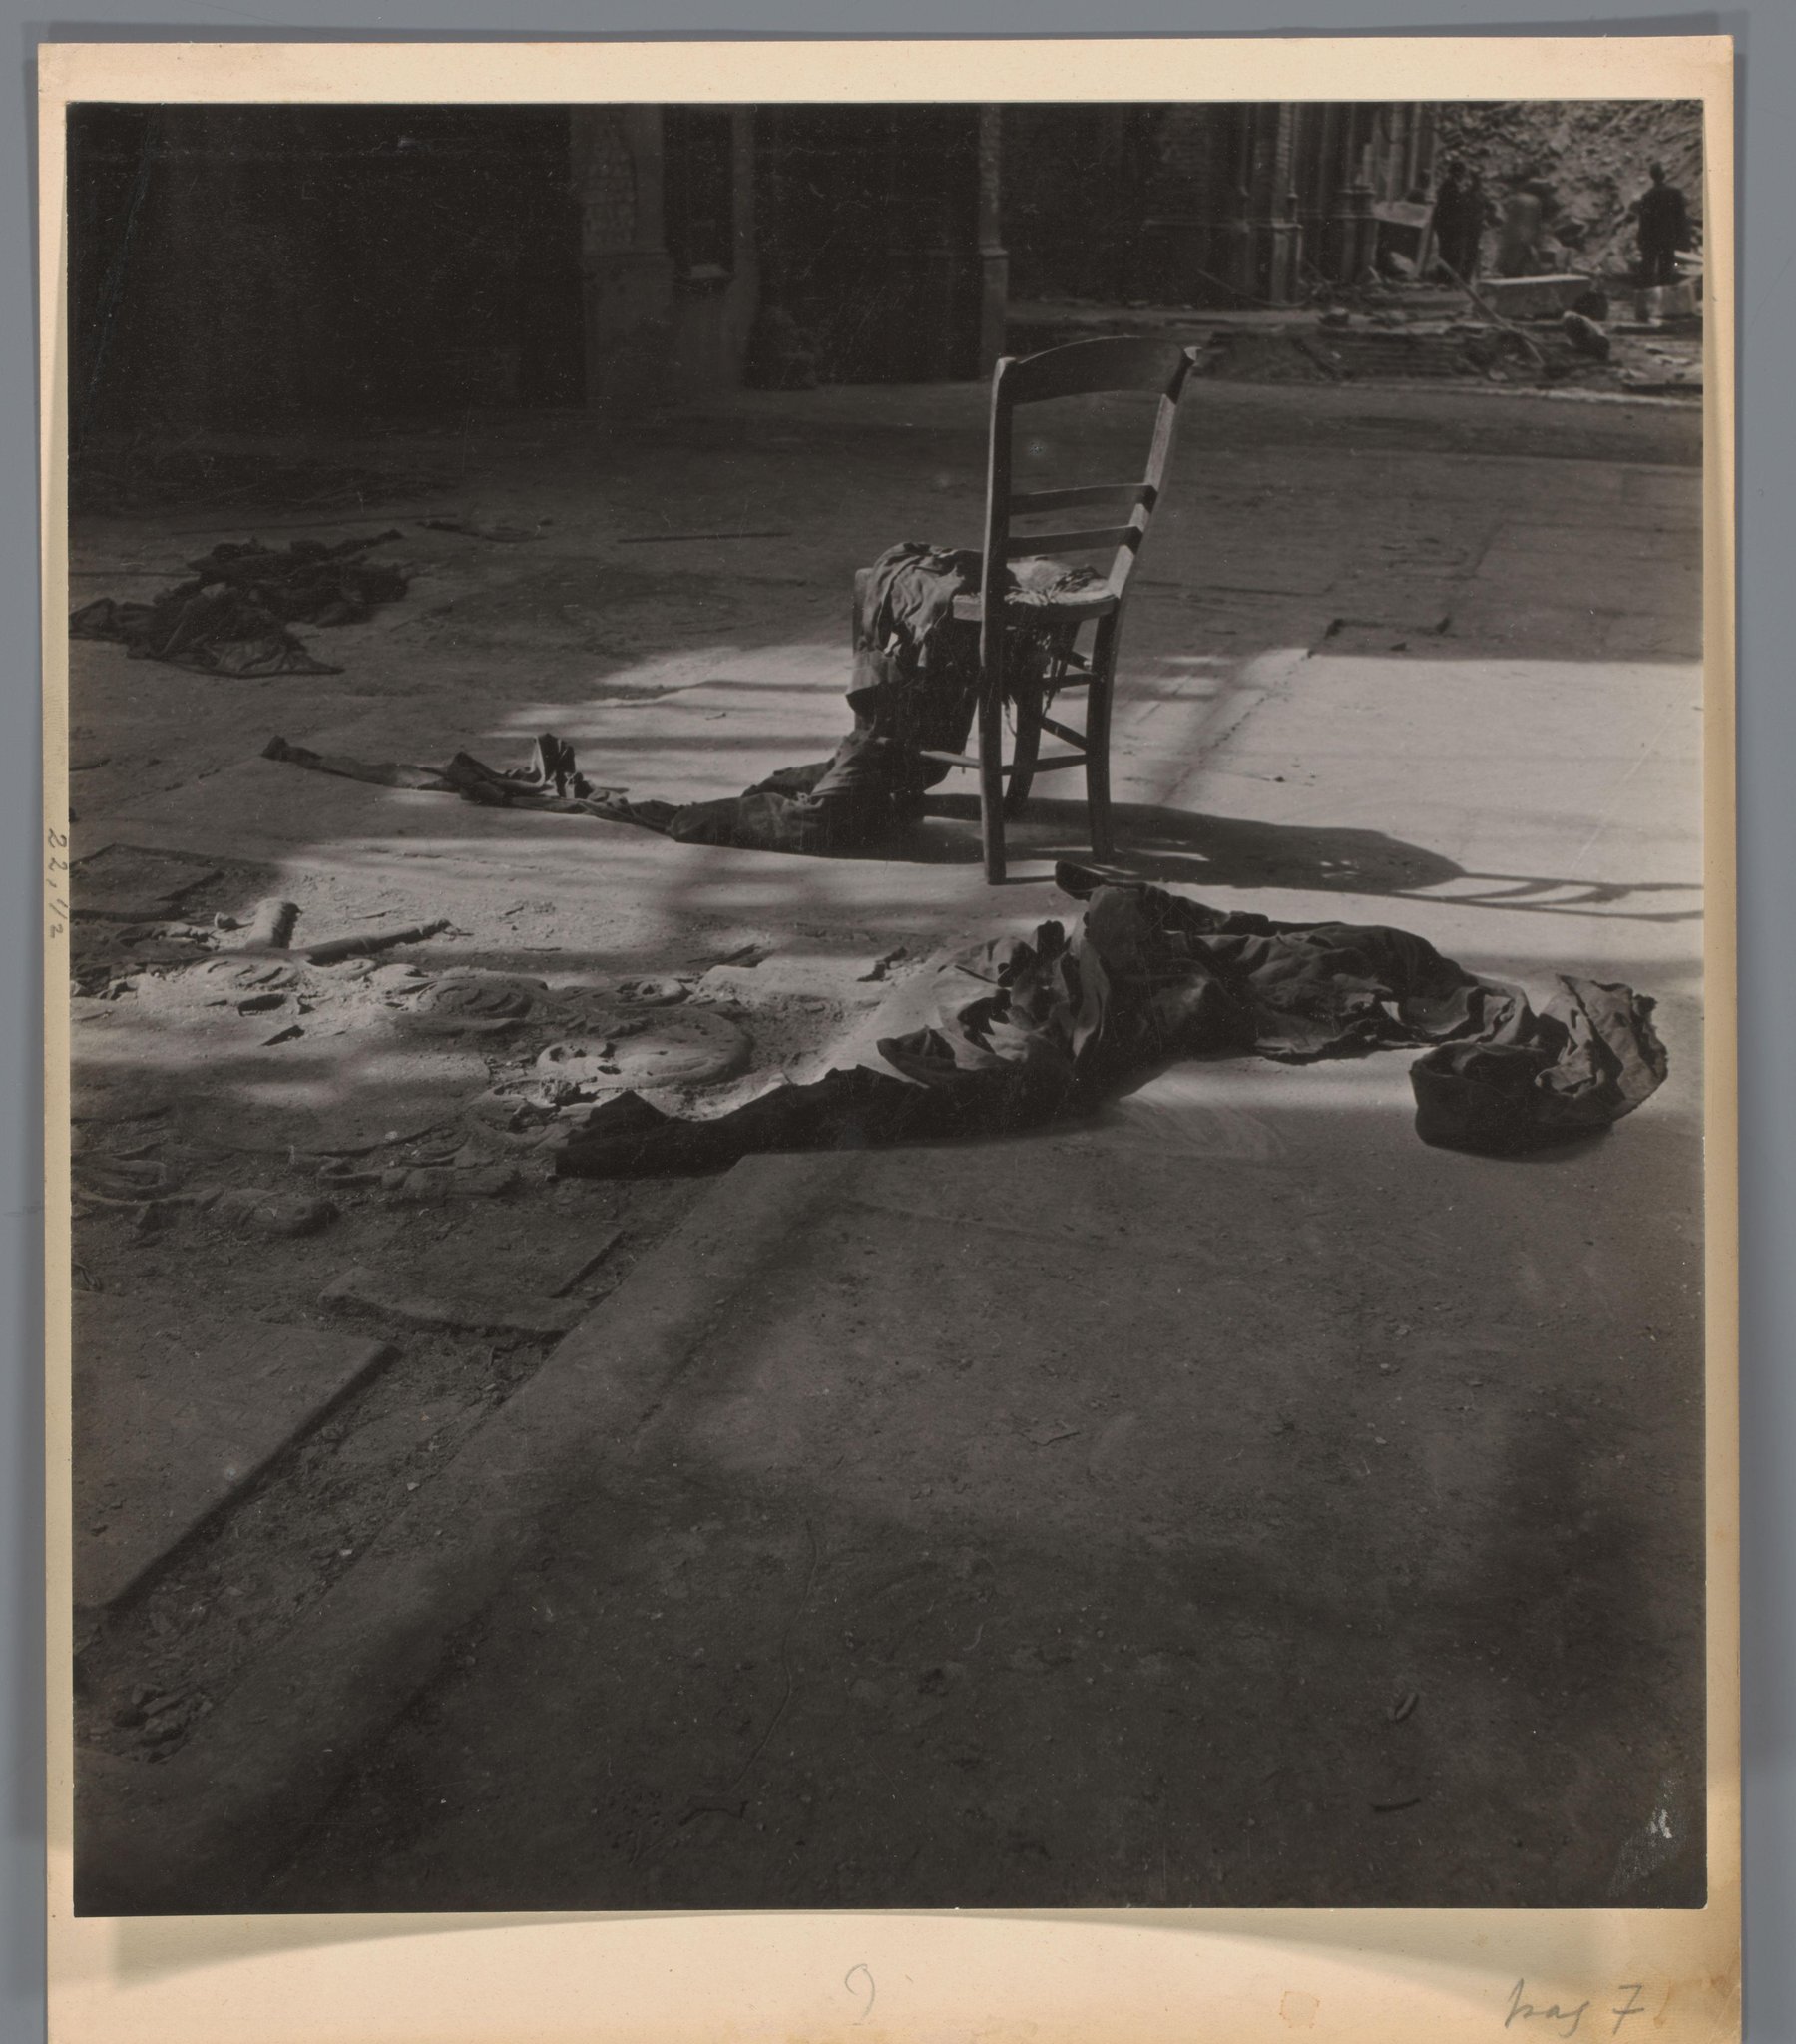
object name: photograph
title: Stilleven met stoel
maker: emmy eugenie andriesse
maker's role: fotograaf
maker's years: 1914-1953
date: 1945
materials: cardboard, photographic support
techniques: gelatin silver print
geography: arnhem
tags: chair